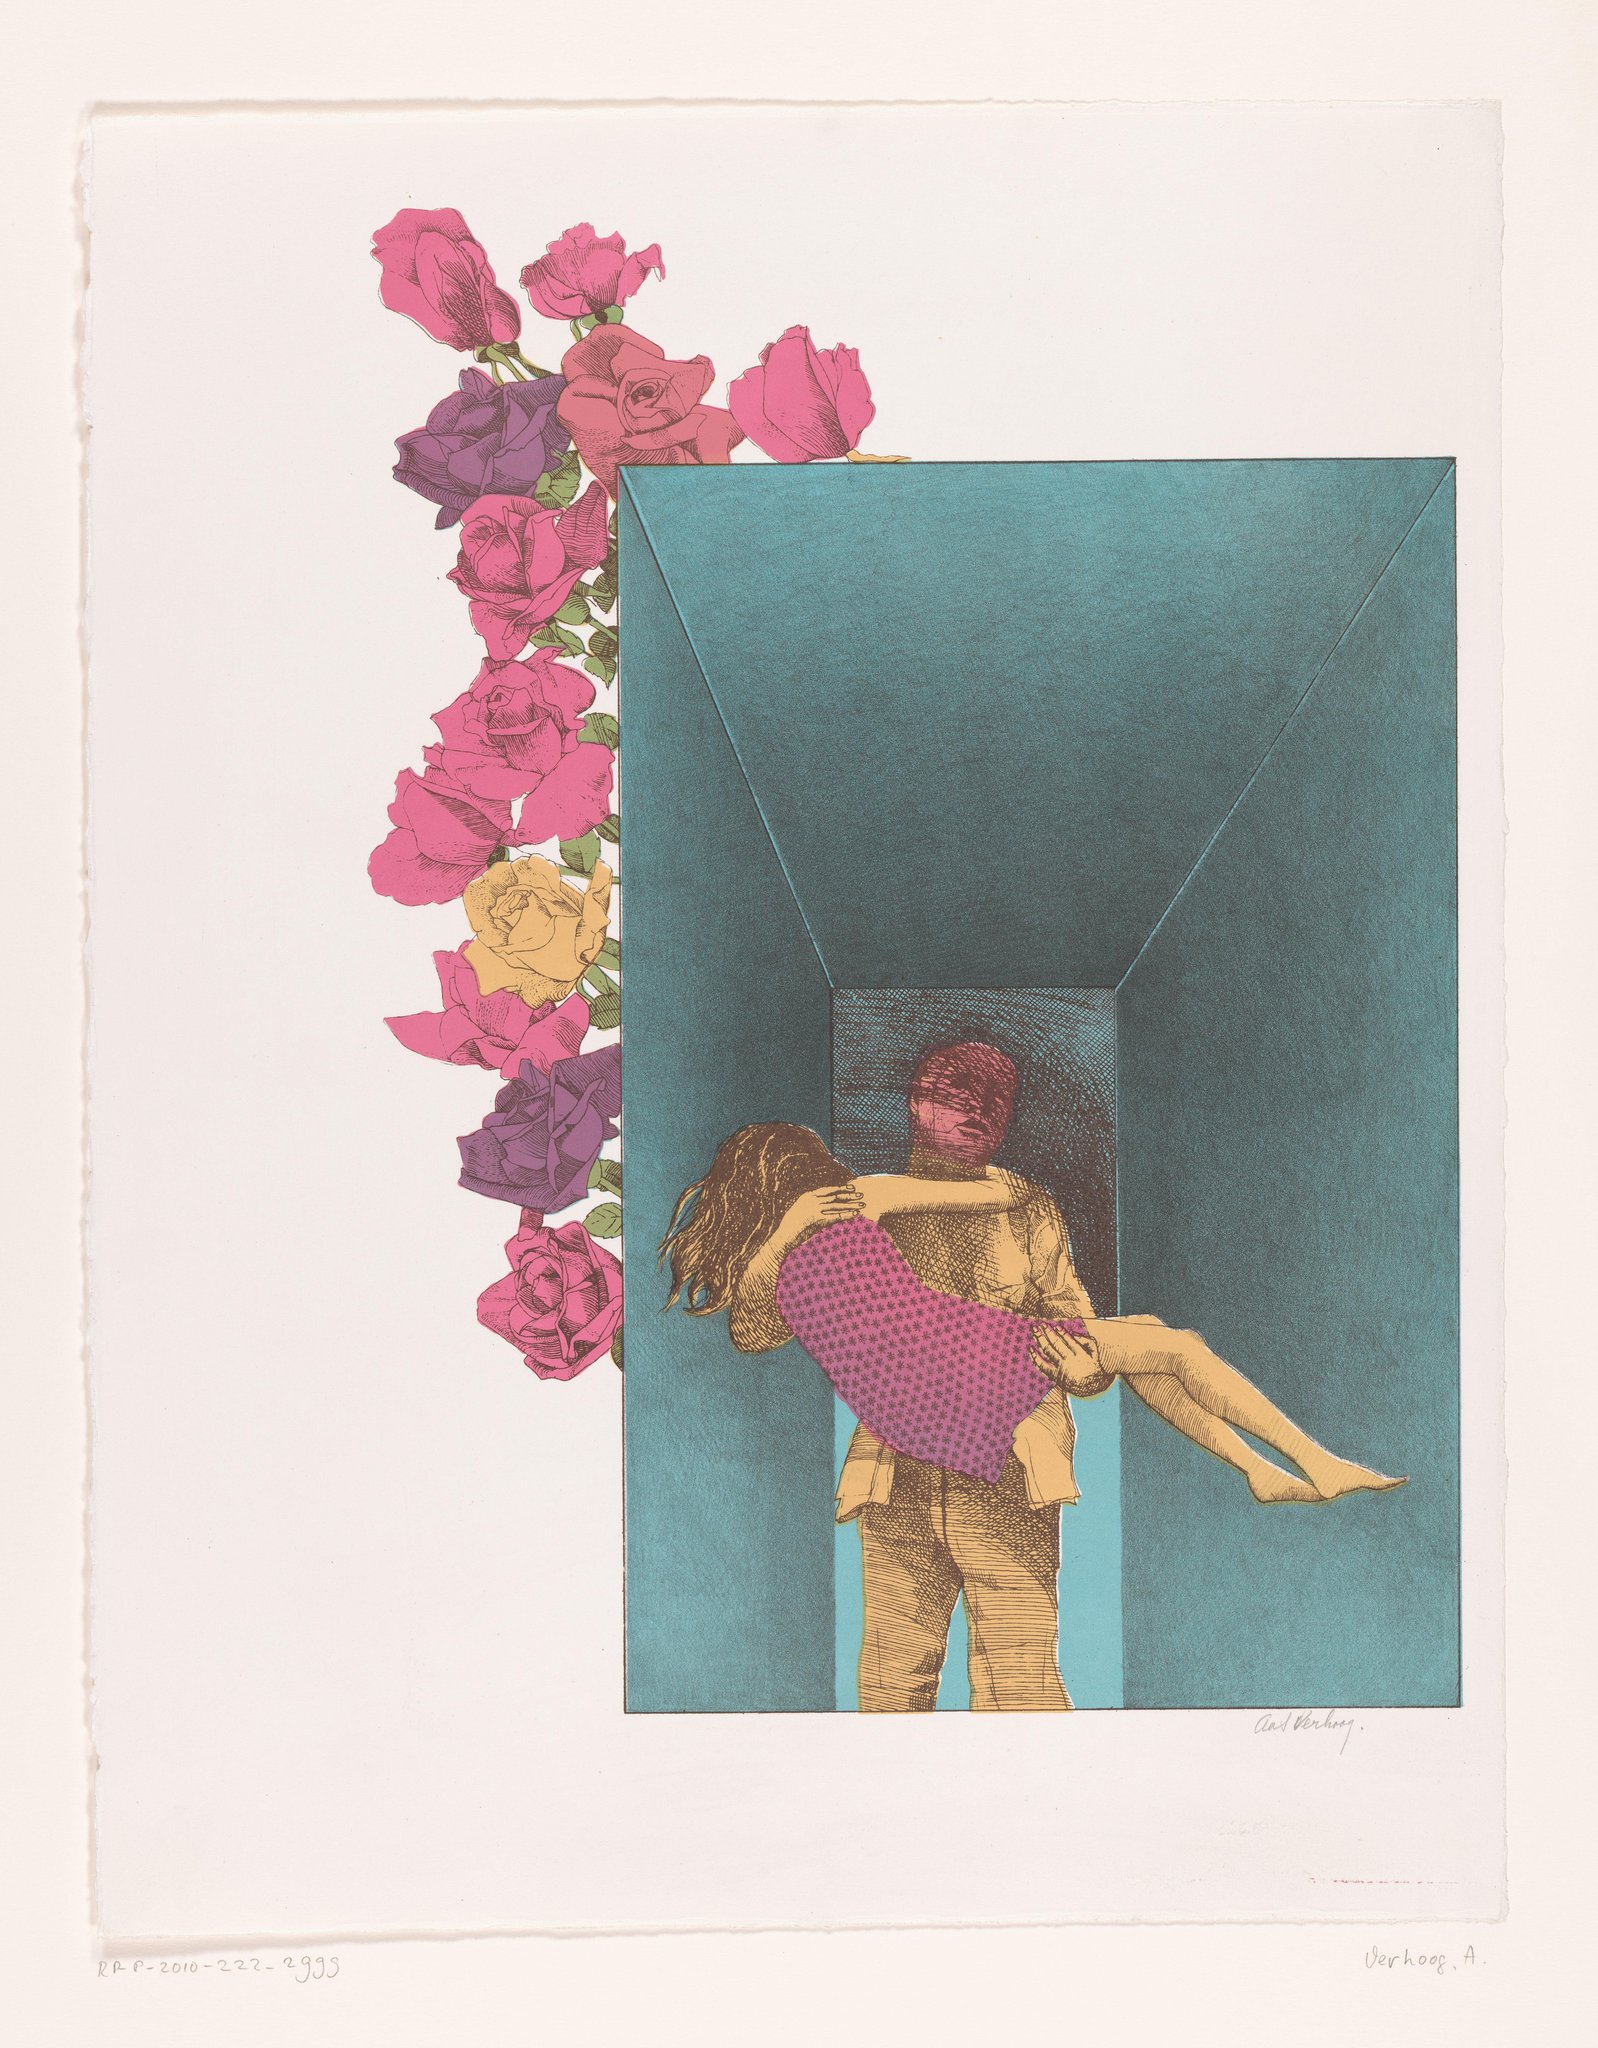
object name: print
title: Man draagt vrouw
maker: aat verhoog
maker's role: print maker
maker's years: 1933-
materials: paper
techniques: lithograph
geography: netherlands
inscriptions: signature: ‘Aat Verhoog’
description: Man draagt vrouw in zijn armen in blauwe gang, rechts omkaderd door veelkleurige rozen.